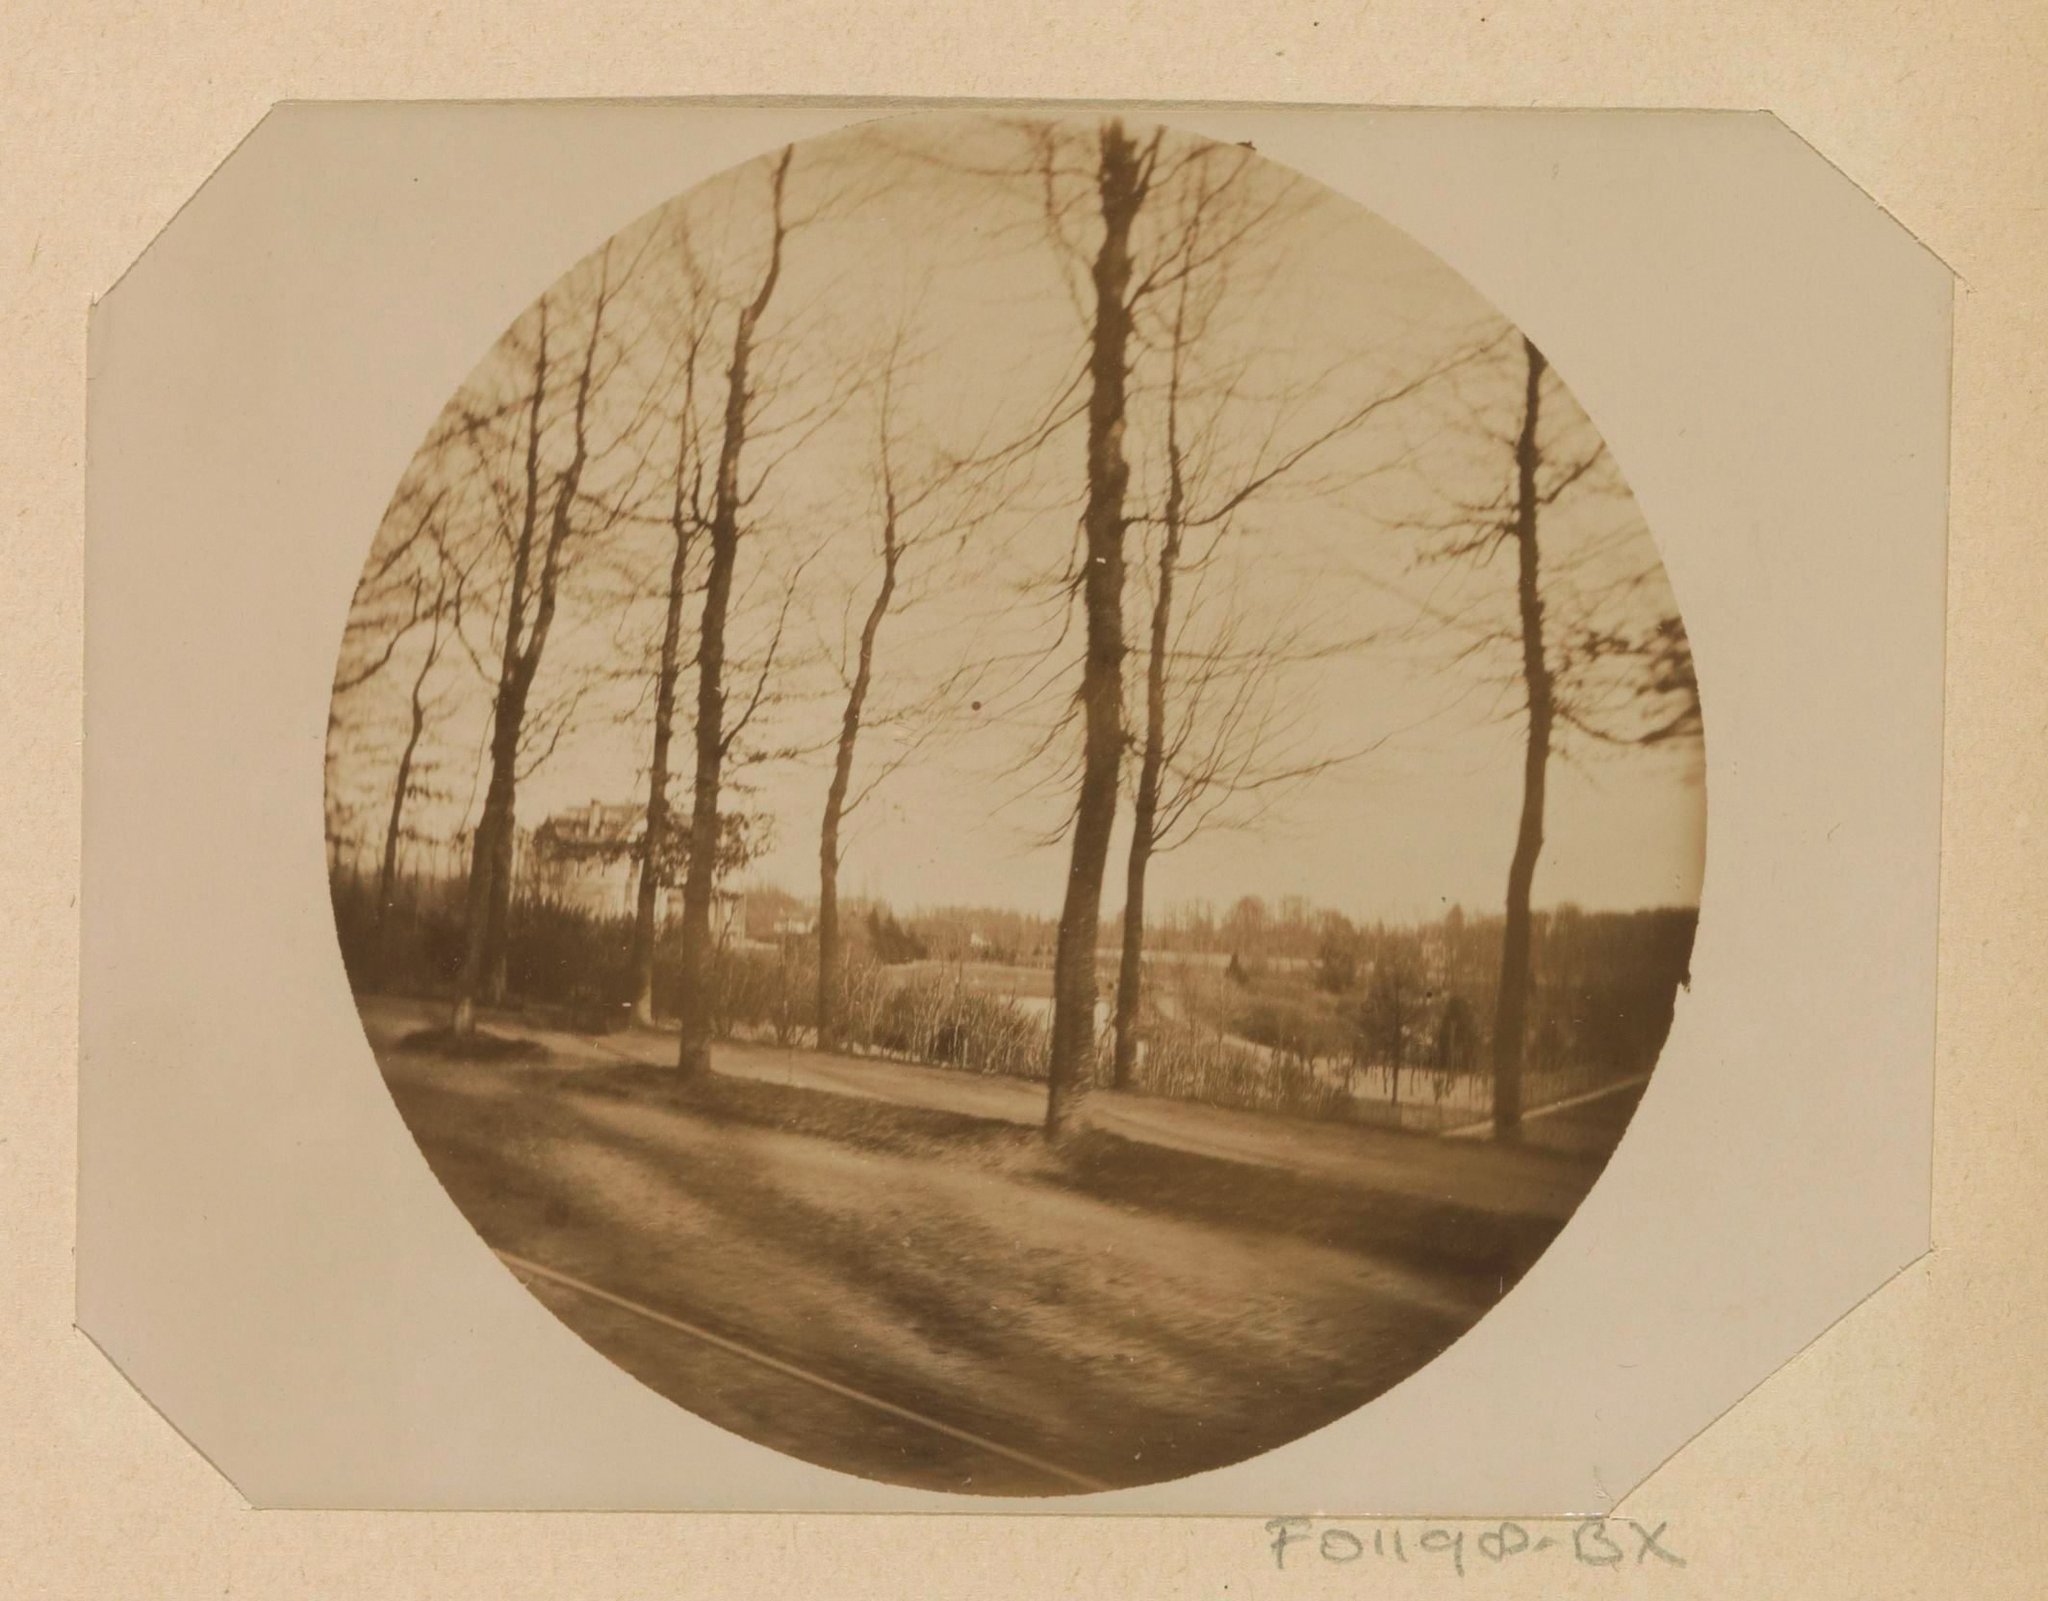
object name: album leaf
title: landschap vanuit een rijtuig, mogelijk nabij Warnsborn bij Arnhem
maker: johanna margaretha piek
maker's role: fotograaf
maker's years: 1870-1947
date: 1889-1893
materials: paper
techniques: gelatin silver print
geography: arnhem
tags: forest path or lane, arnhem